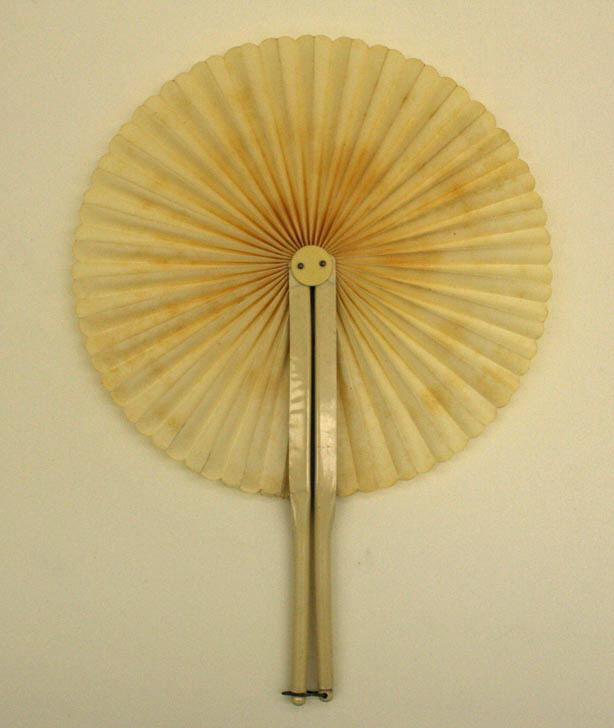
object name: fan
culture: american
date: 1860-1869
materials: metal, paper, wood